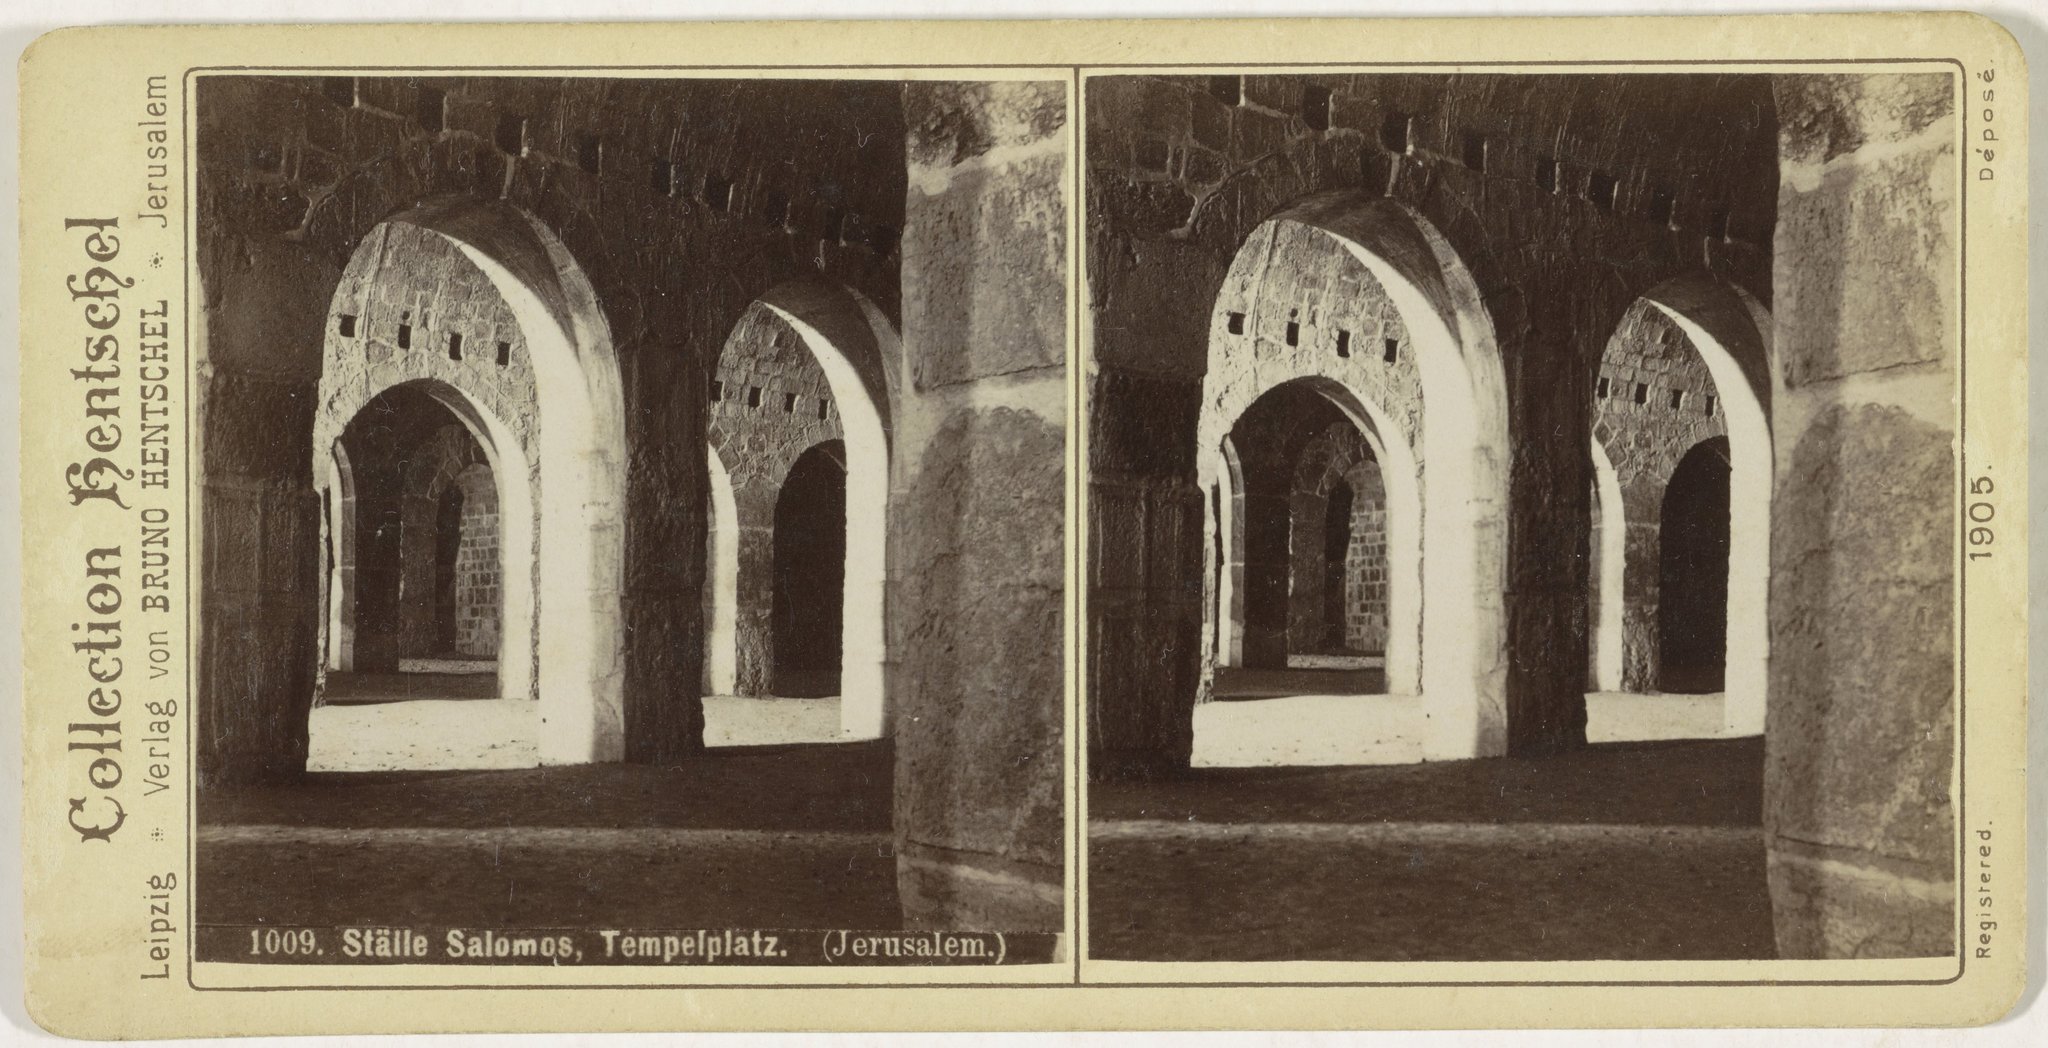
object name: stereograph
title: Collection Hentschel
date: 1905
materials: cardboard, paper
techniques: albumen print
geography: leipzig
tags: ritual practices ~ islam, mohammedanism, solomon's stables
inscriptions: inscription: ‘Registered.’, number: ‘1009.’, inscription: ‘Dépose.’